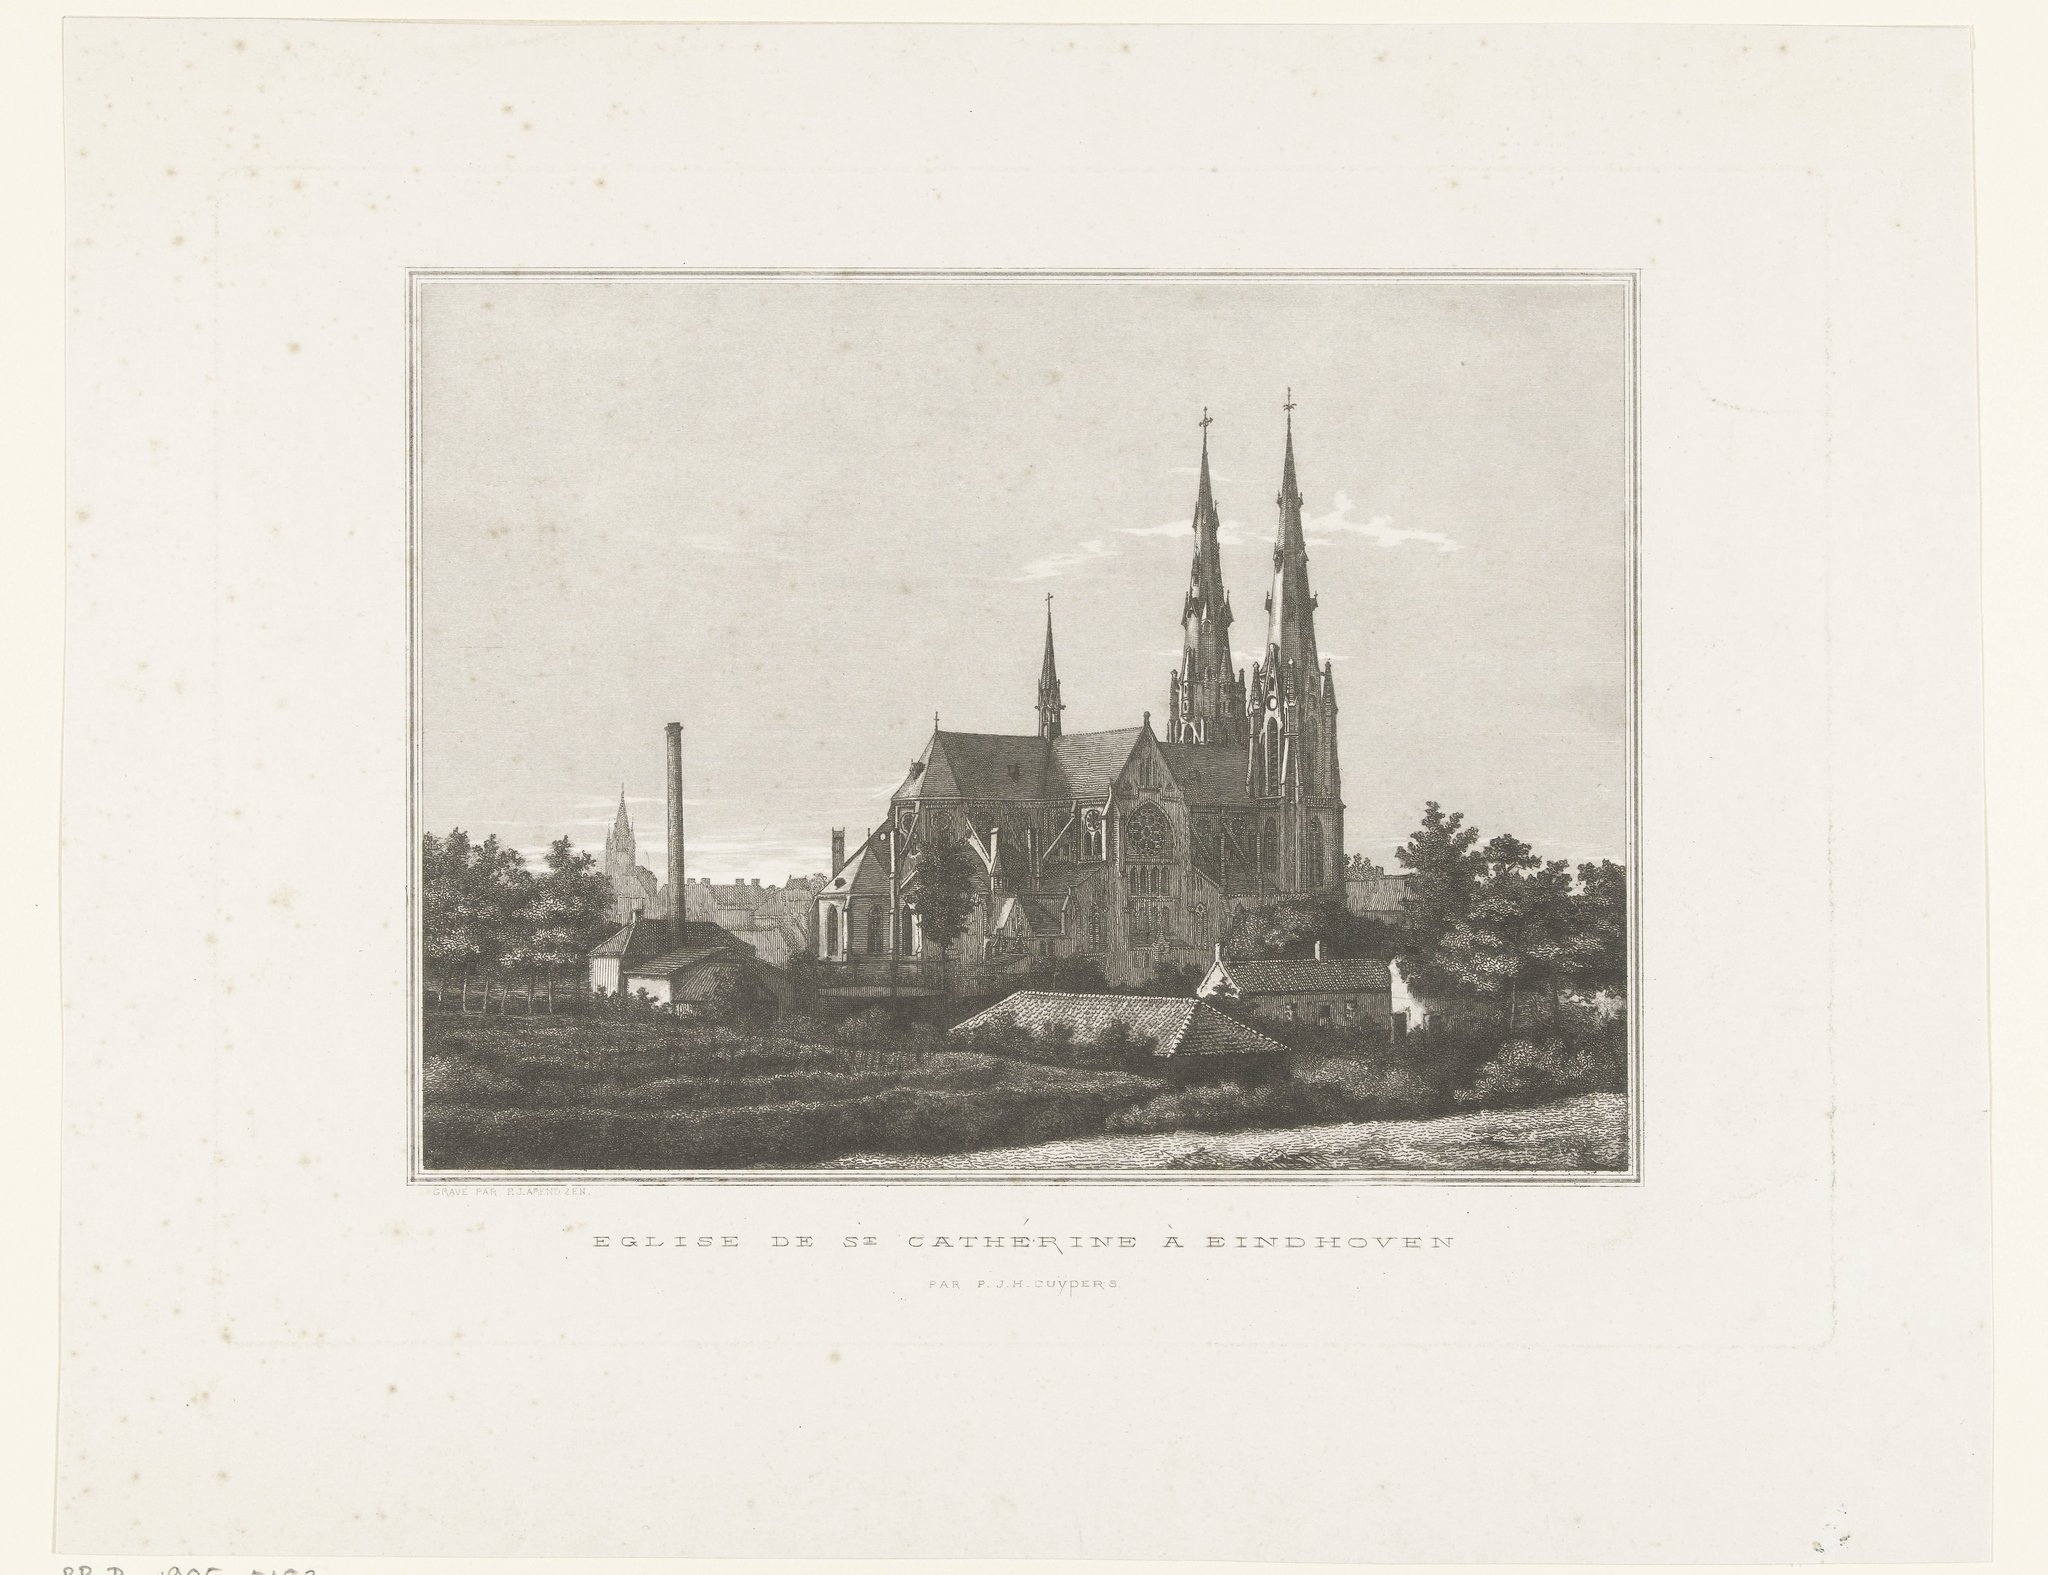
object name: print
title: Eglise de St Catherine à Eindhoven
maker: petrus johannes arendzen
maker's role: draughtsman, print maker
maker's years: 1846-1932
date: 1867-1880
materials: paper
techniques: etching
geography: netherlands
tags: cathrien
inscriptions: collector's mark: Lugt 2228, inscription: ‘P.J. Arendzen’